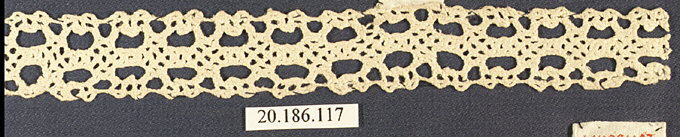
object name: insertion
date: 1501-1600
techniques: lace